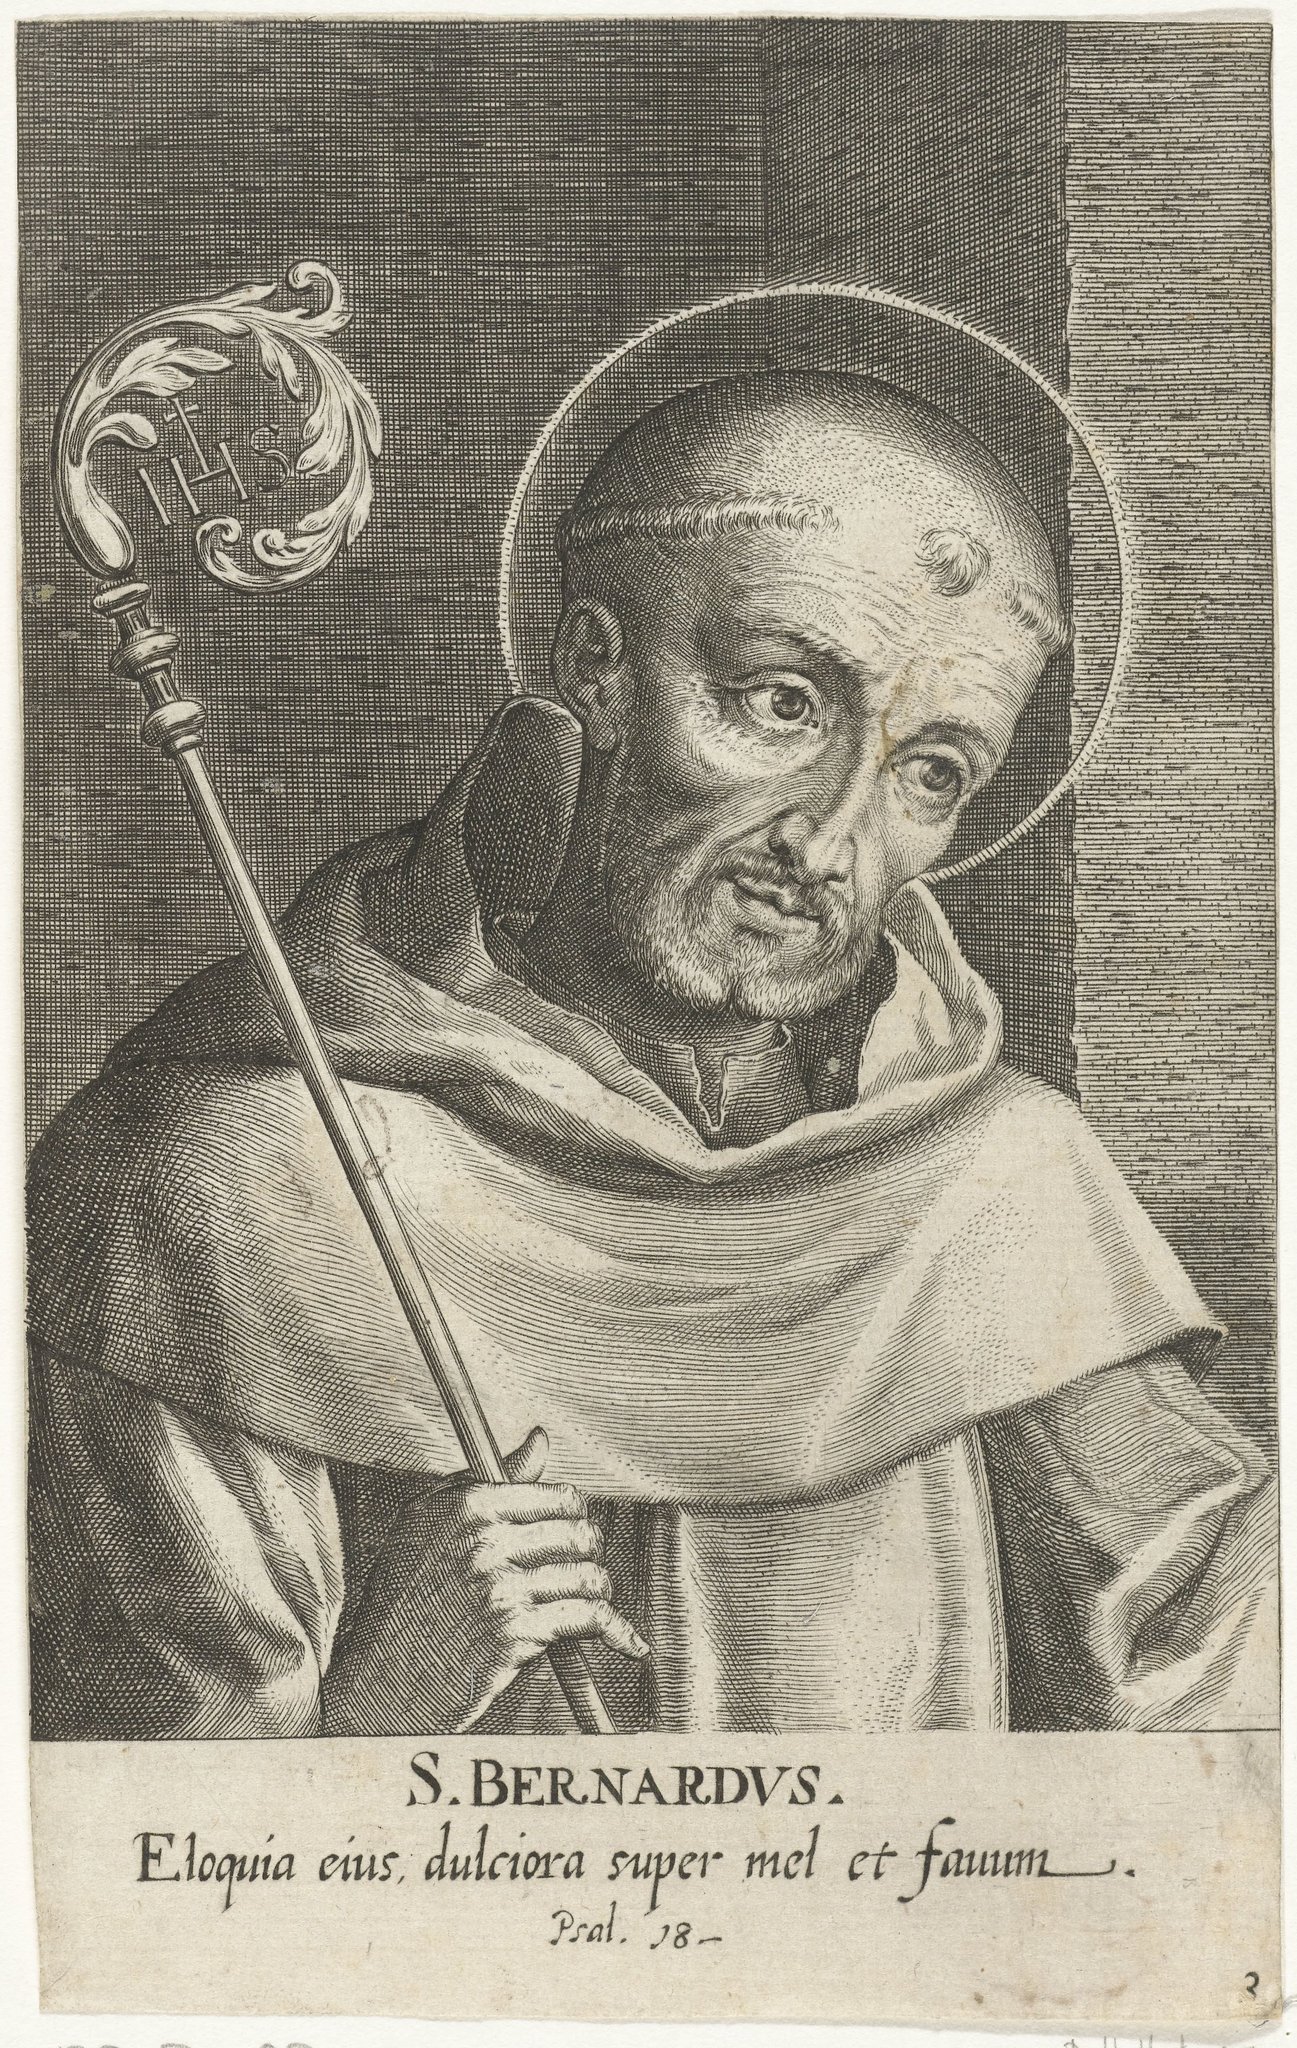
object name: print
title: Icones Institutorum sex illustrium in Christiana religione ordinum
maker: dominicus custos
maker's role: print maker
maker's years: 1560-1615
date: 1579-1615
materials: paper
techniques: engraving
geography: augsburg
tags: bernard of clairvaux, cistercian monk and abbot; possible attributes: beehive, chained dragon, crucifix, cross with instruments of the passion, (three) mitre at his feet, white dog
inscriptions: collector's mark: Lugt 240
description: De heilige Bernardus van Clairvaux, hervormer van de Cisterciënzer orde, met monnikspij en bisschopsstaf.